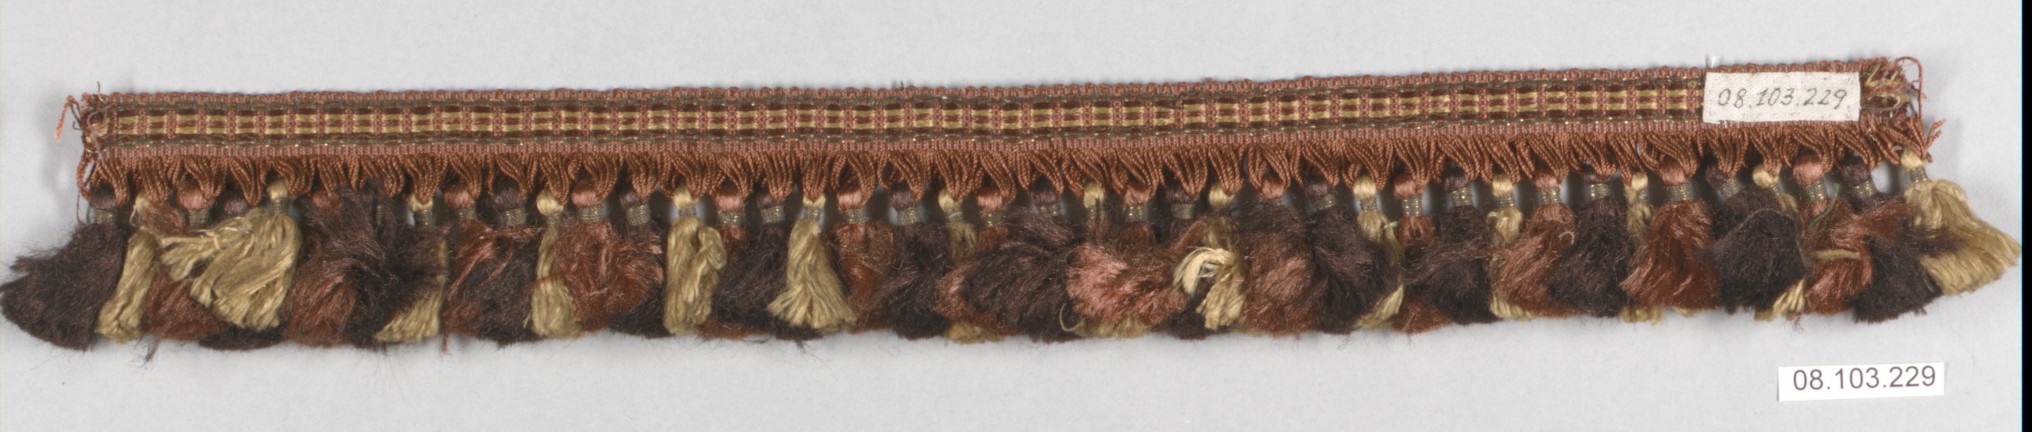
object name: fringe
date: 1801-1900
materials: silk